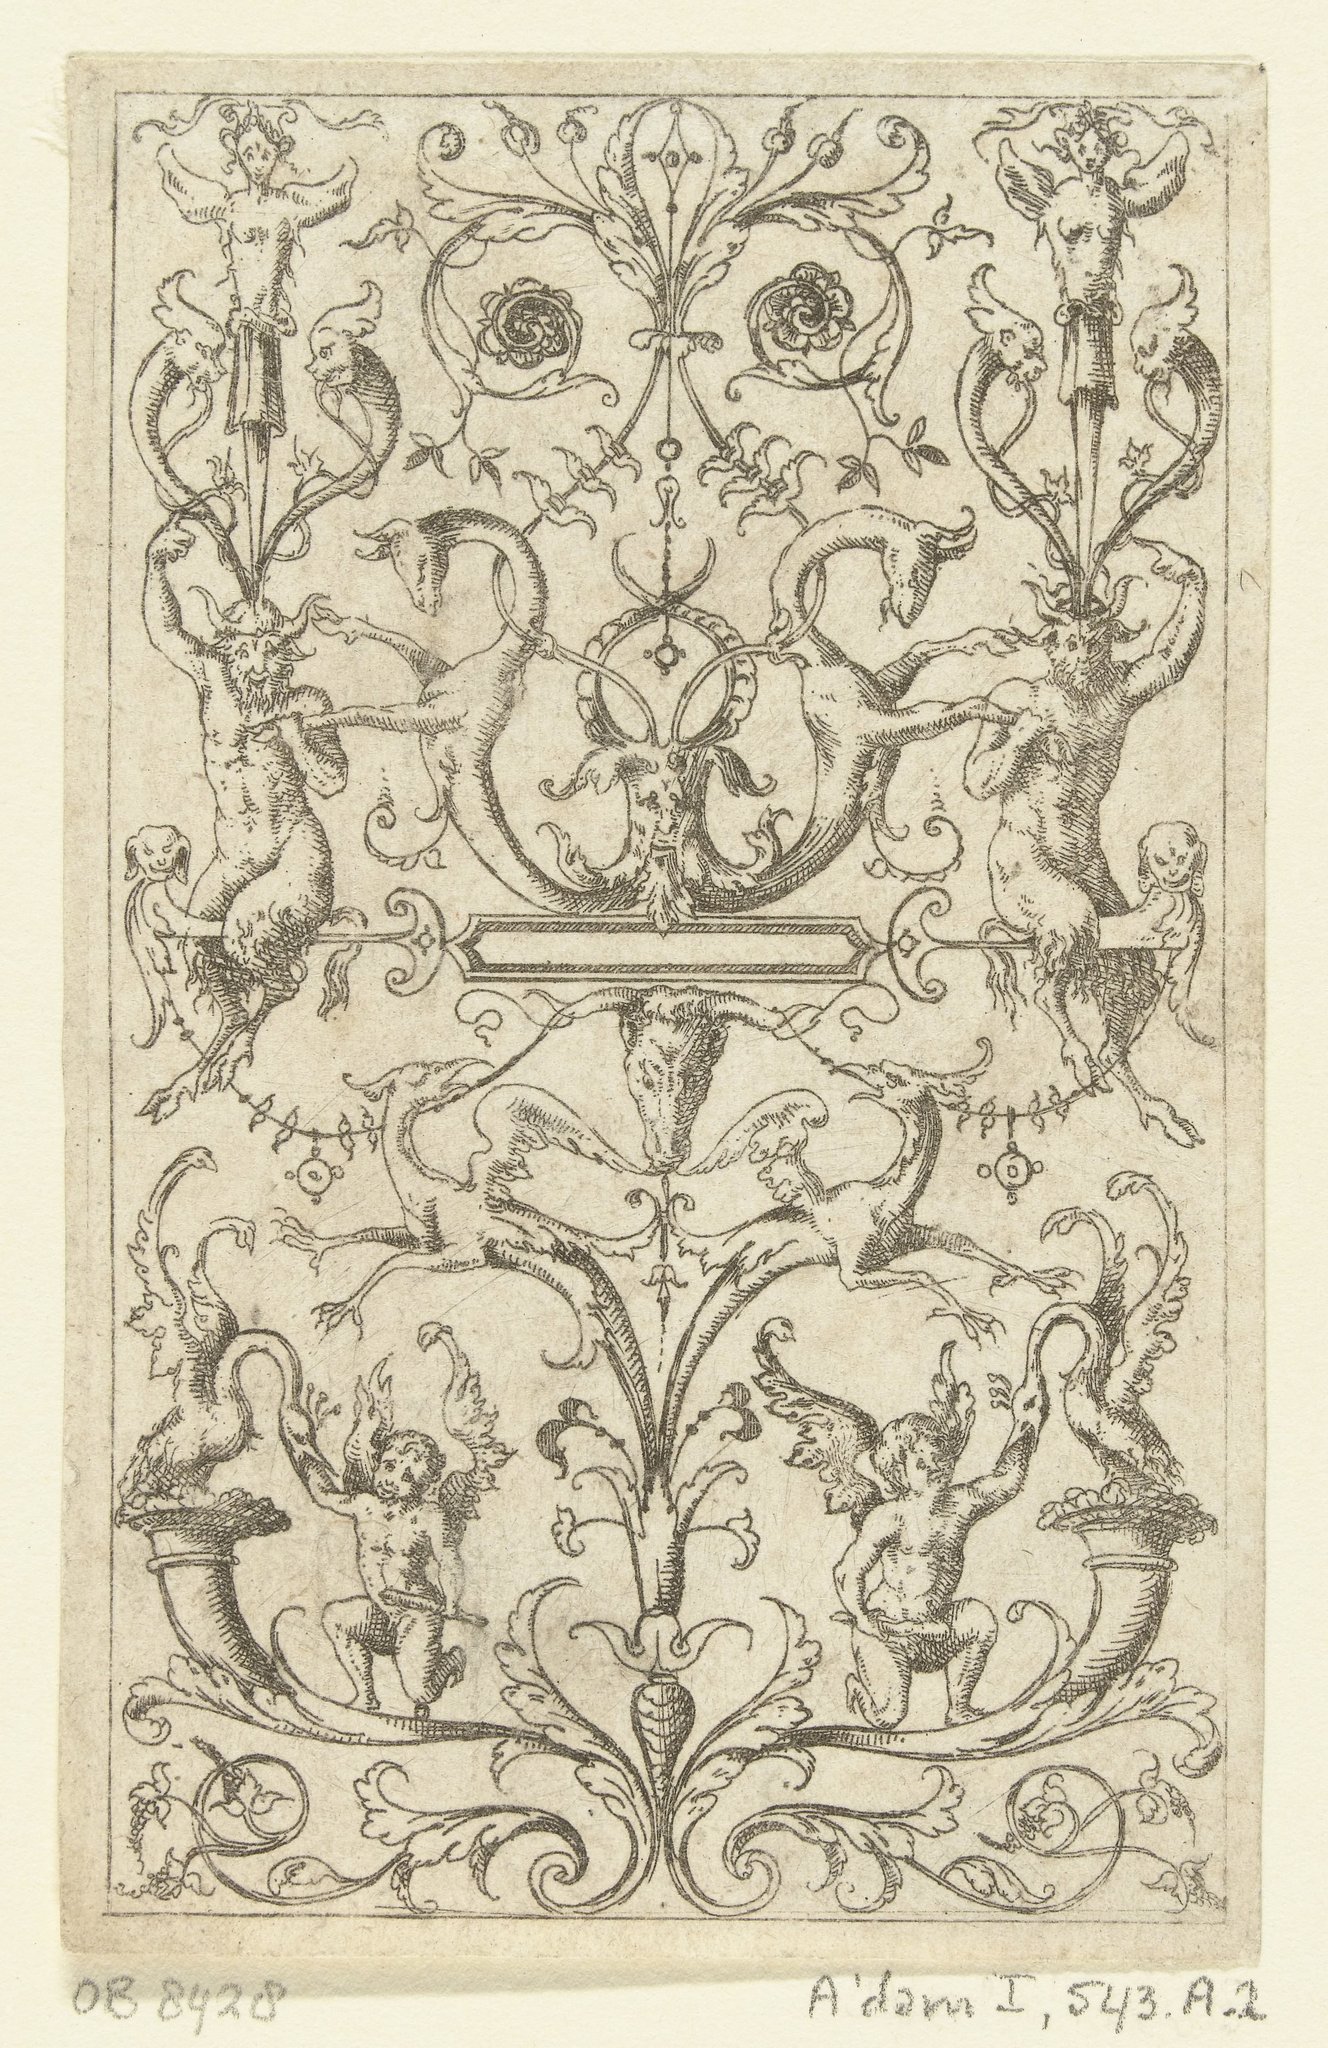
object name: print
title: Kandelaber met onderaan zowel links als rechts een bladrank die uitloopt in een hoorn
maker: Anonymous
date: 1500-1600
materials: paper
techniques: etching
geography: france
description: Op de hoorn zit een vogel die in de arm van een putto hapt. Gelijkzijdige kopie (?) naar prent van Jacques Androuet Ducerceau, die een vlakdecoratie van de Meester van de Paardenhoofden kopieerde en verdubbelde.